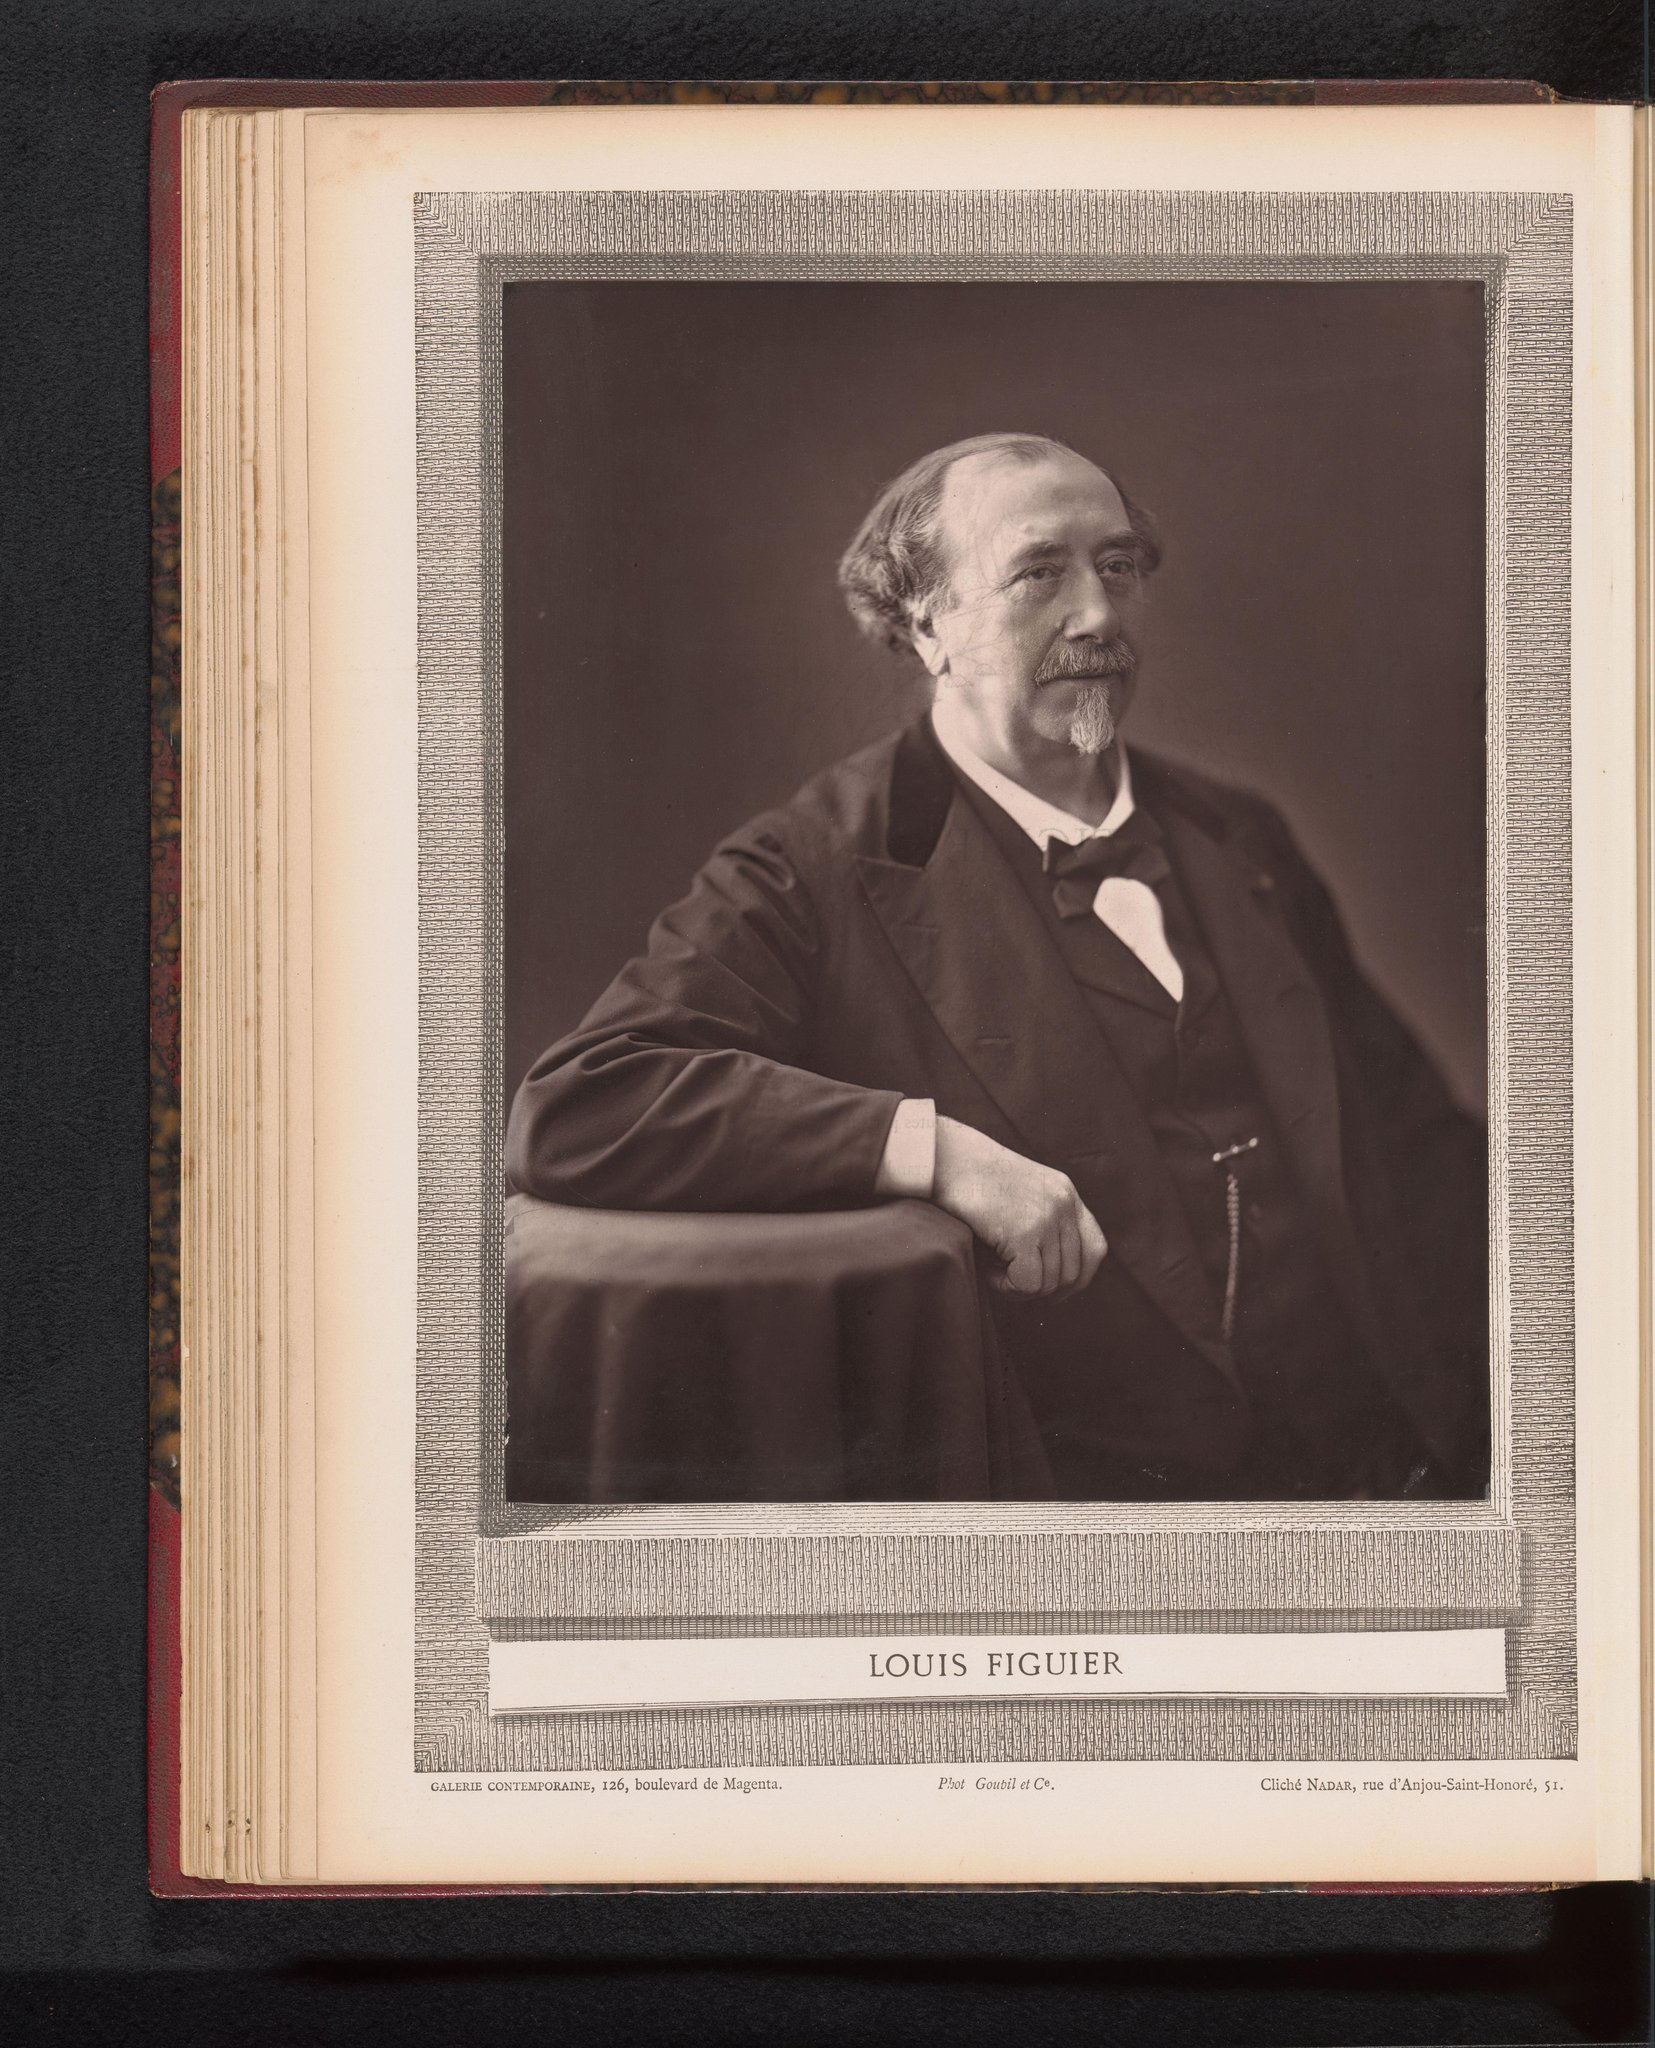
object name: page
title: Portret van Louis Figuier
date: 1872-1877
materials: paper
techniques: woodburytype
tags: paris, louis figuier, adult man, historical persons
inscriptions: inscription: ‘Galerie Contemporaine, 126, boulevard de Magenta.’